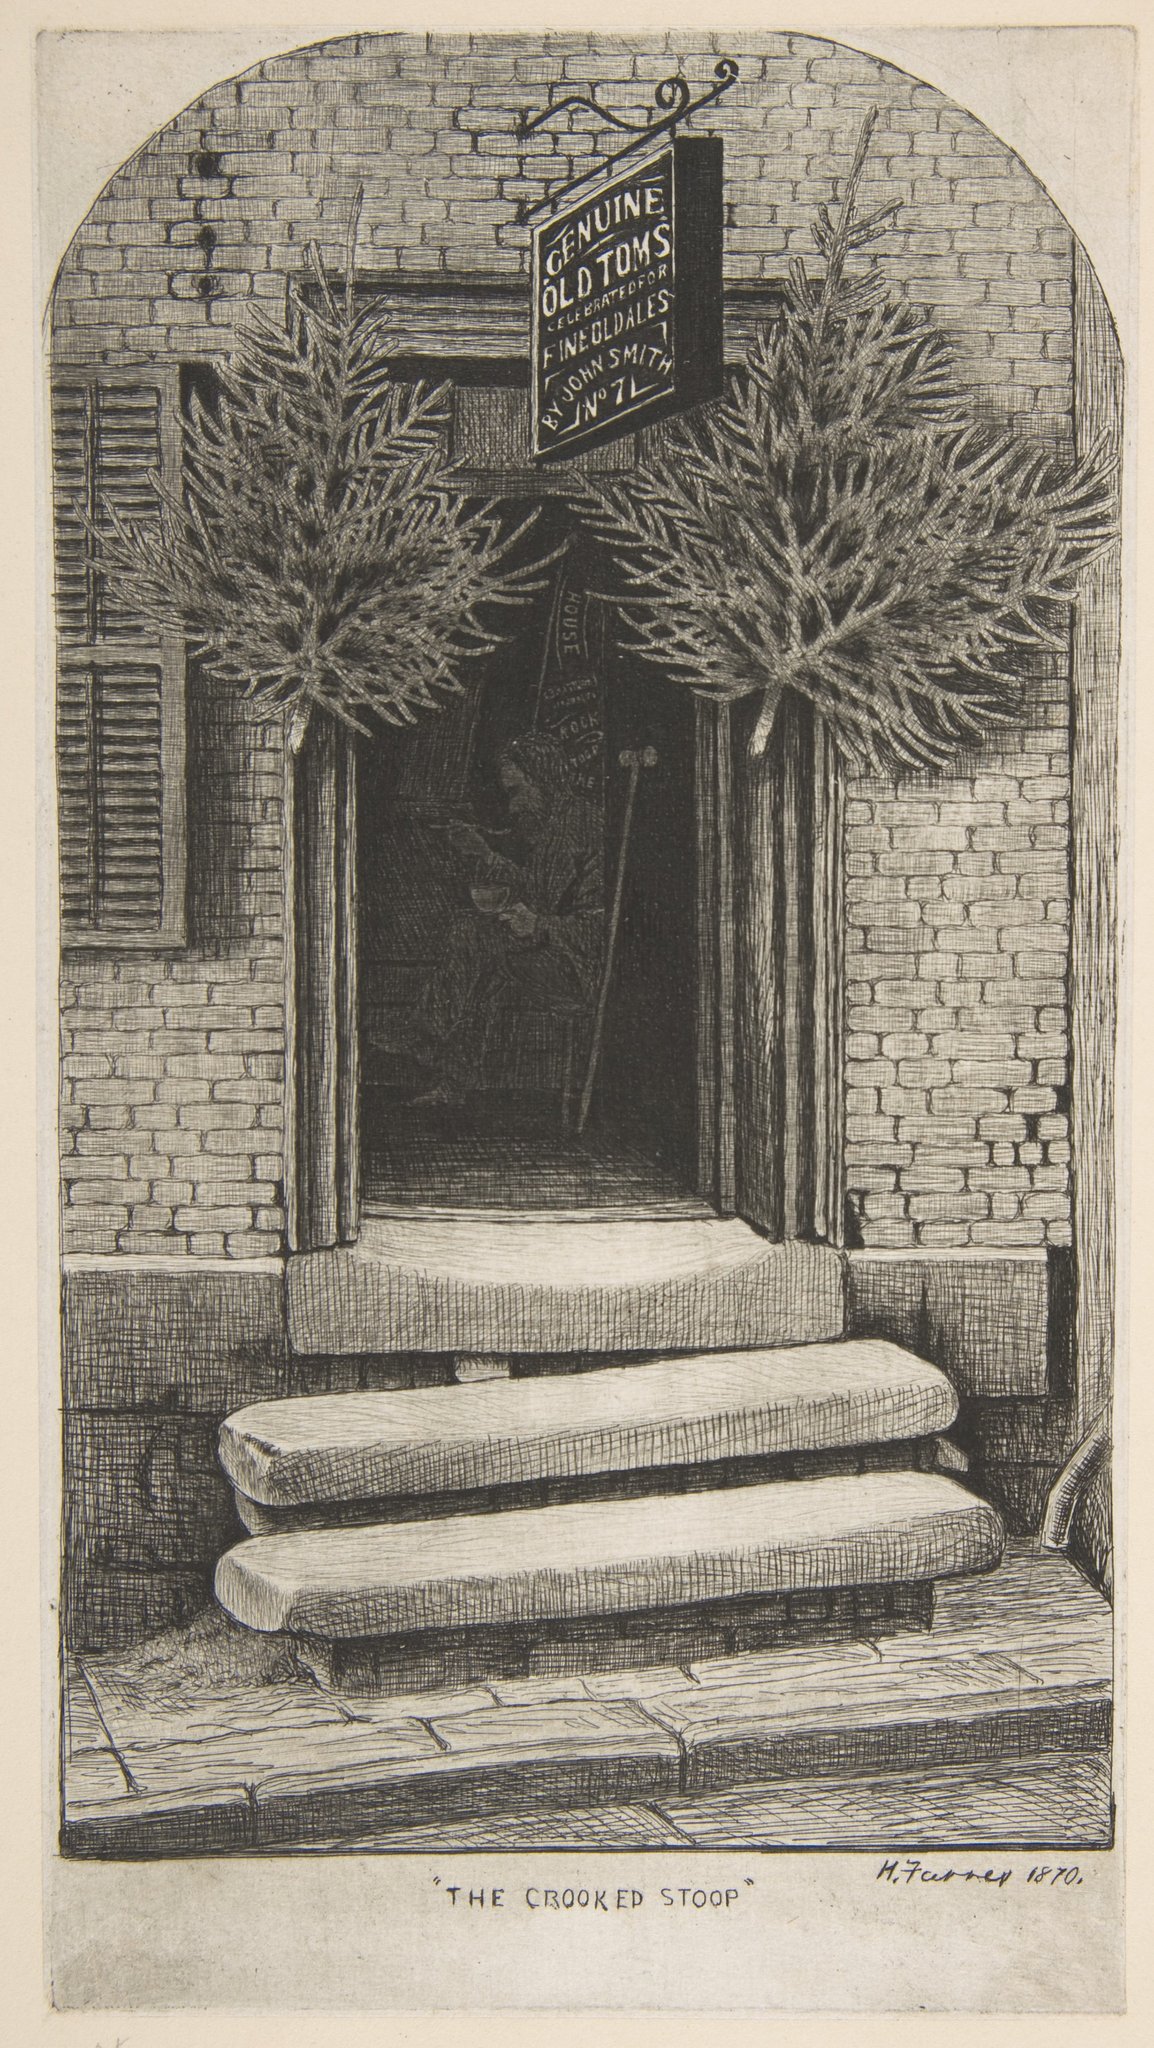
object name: print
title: The Crooked Stoop (Old Tom's Chop House) (from Scenes of Old New York)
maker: henry farrer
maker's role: artist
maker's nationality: american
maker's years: 1844-1903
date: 1870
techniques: etching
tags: doorways,men